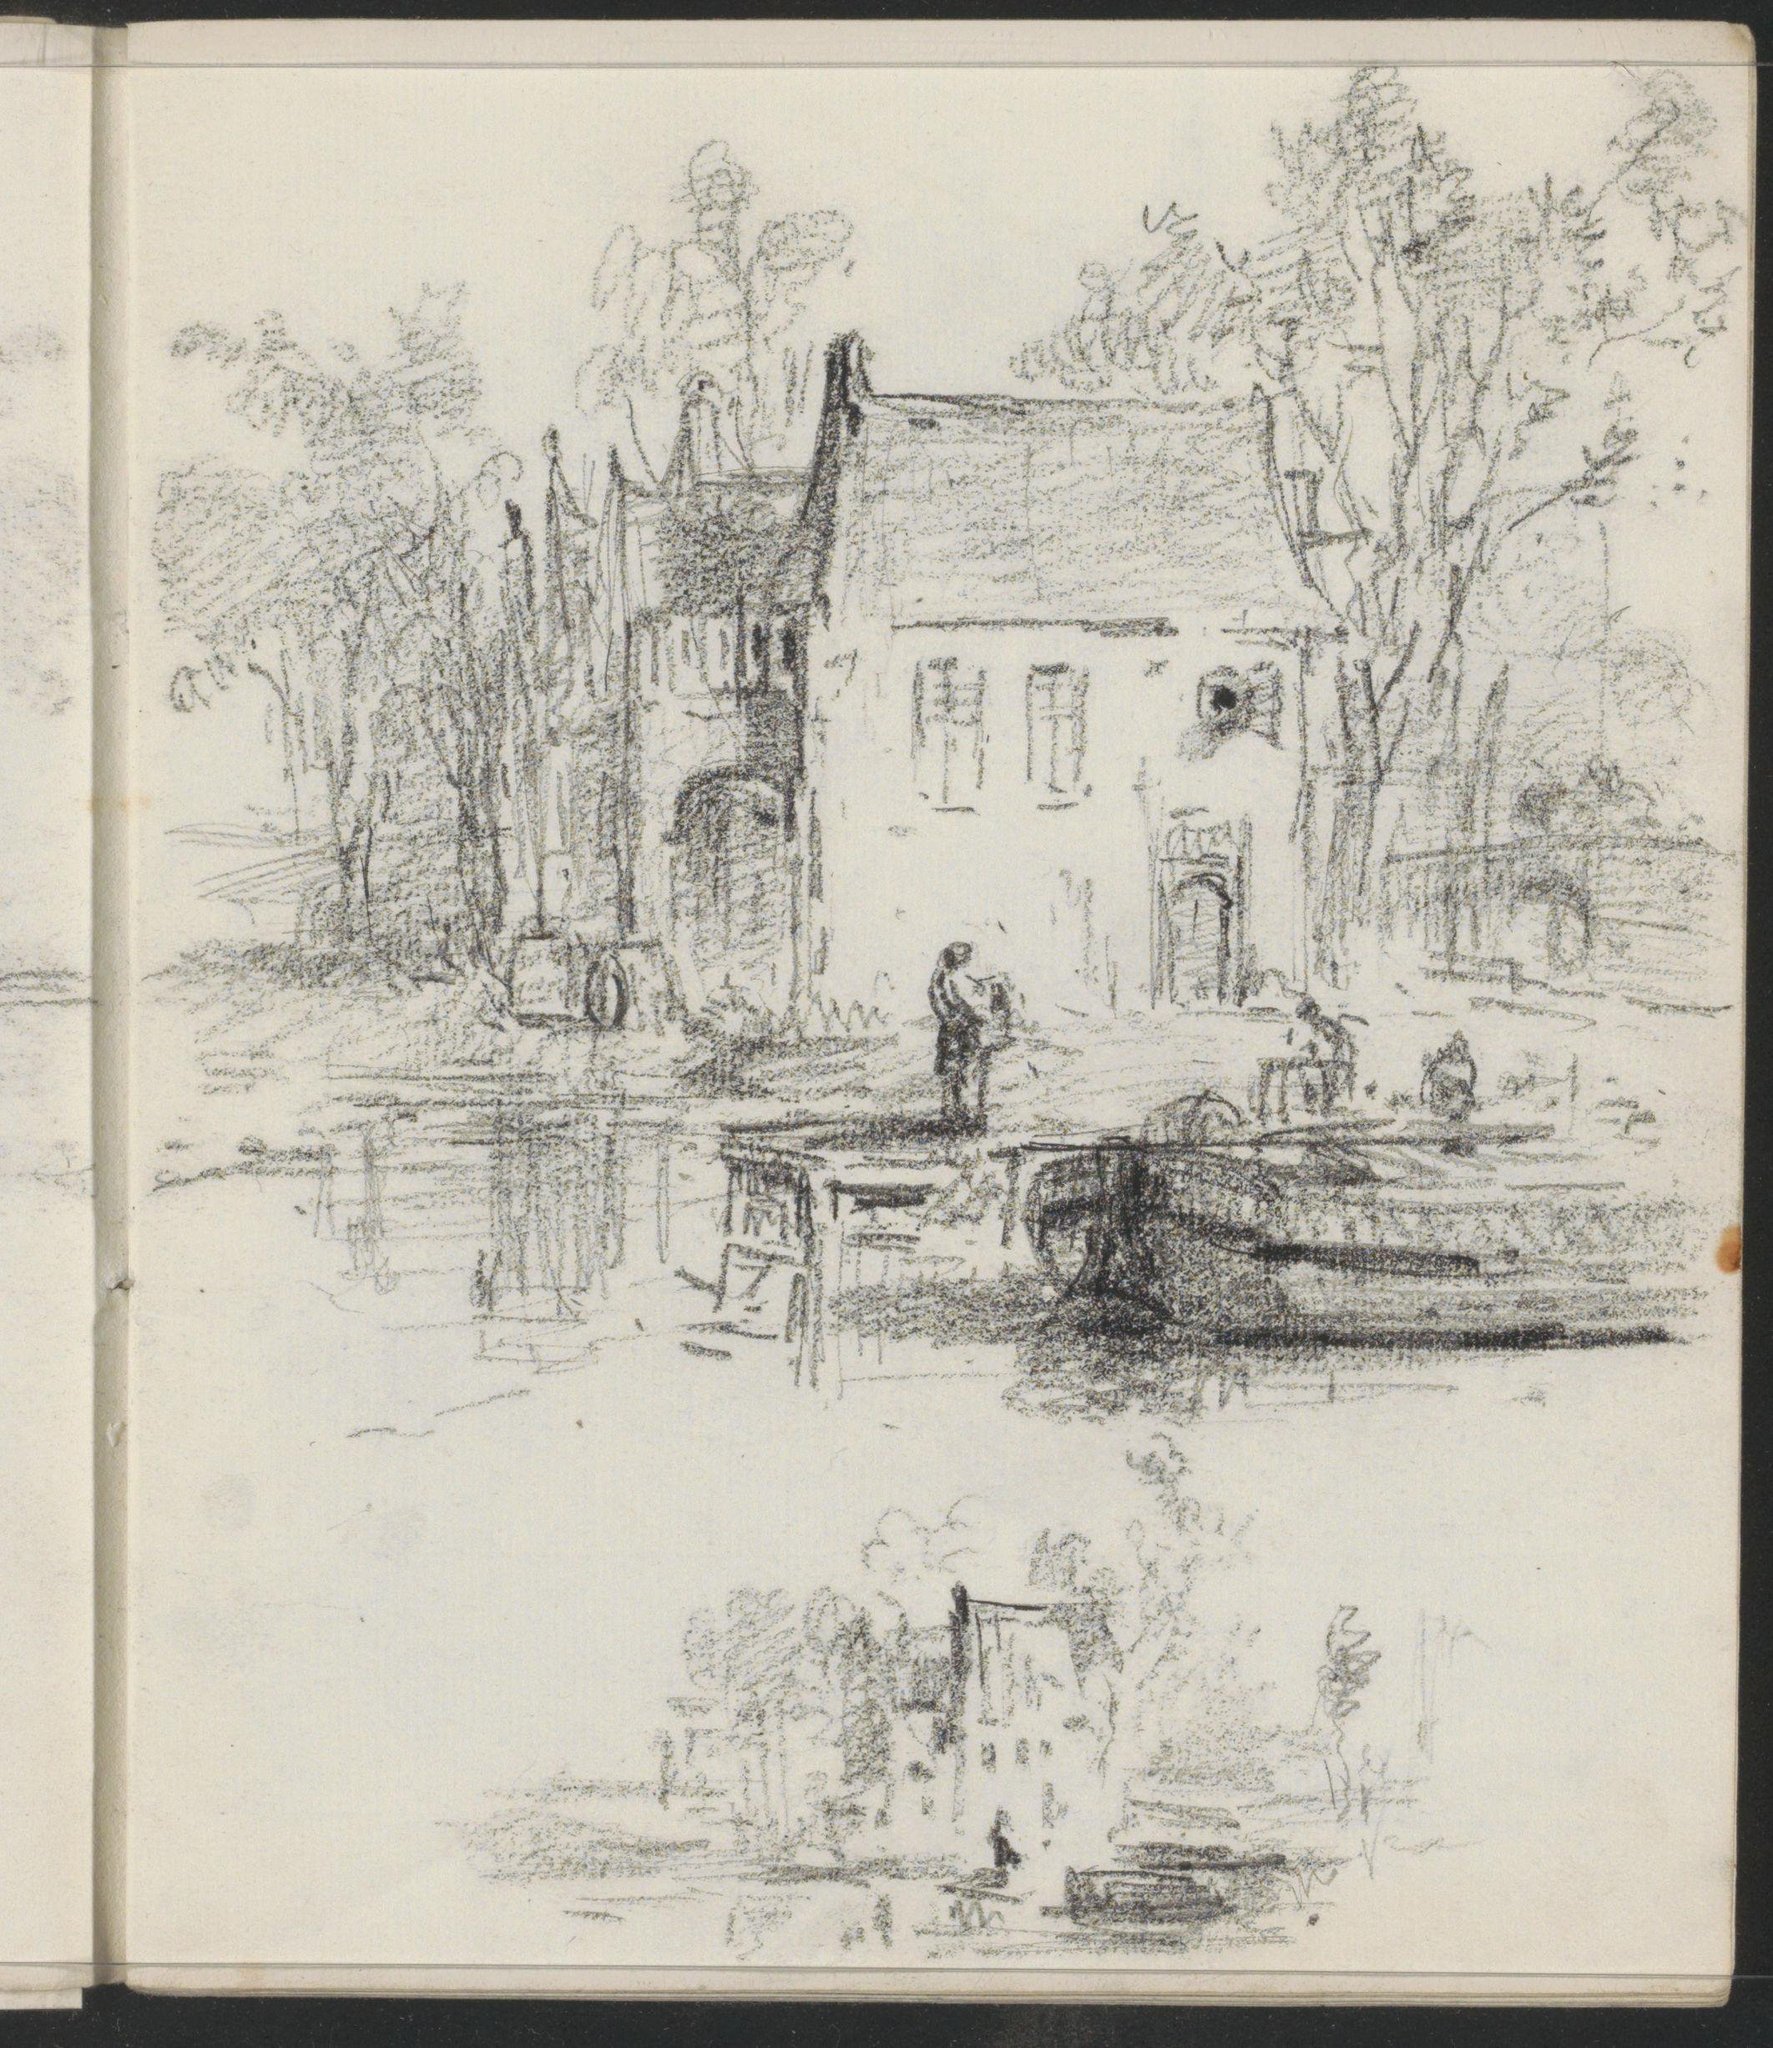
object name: sketchbook leaf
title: Figuren op een steiger naast enkele huizen aan een waterkant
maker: maria vos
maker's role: draughtsman, painter, print maker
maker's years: 1824-1906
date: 1834-1906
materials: paper, pencil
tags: pier, quay, wharf, city-view, and landscape with man-made constructions (+ city(-scape) with figures, staffage)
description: Blad 2 recto uit een schetsboek met 20 bladen.